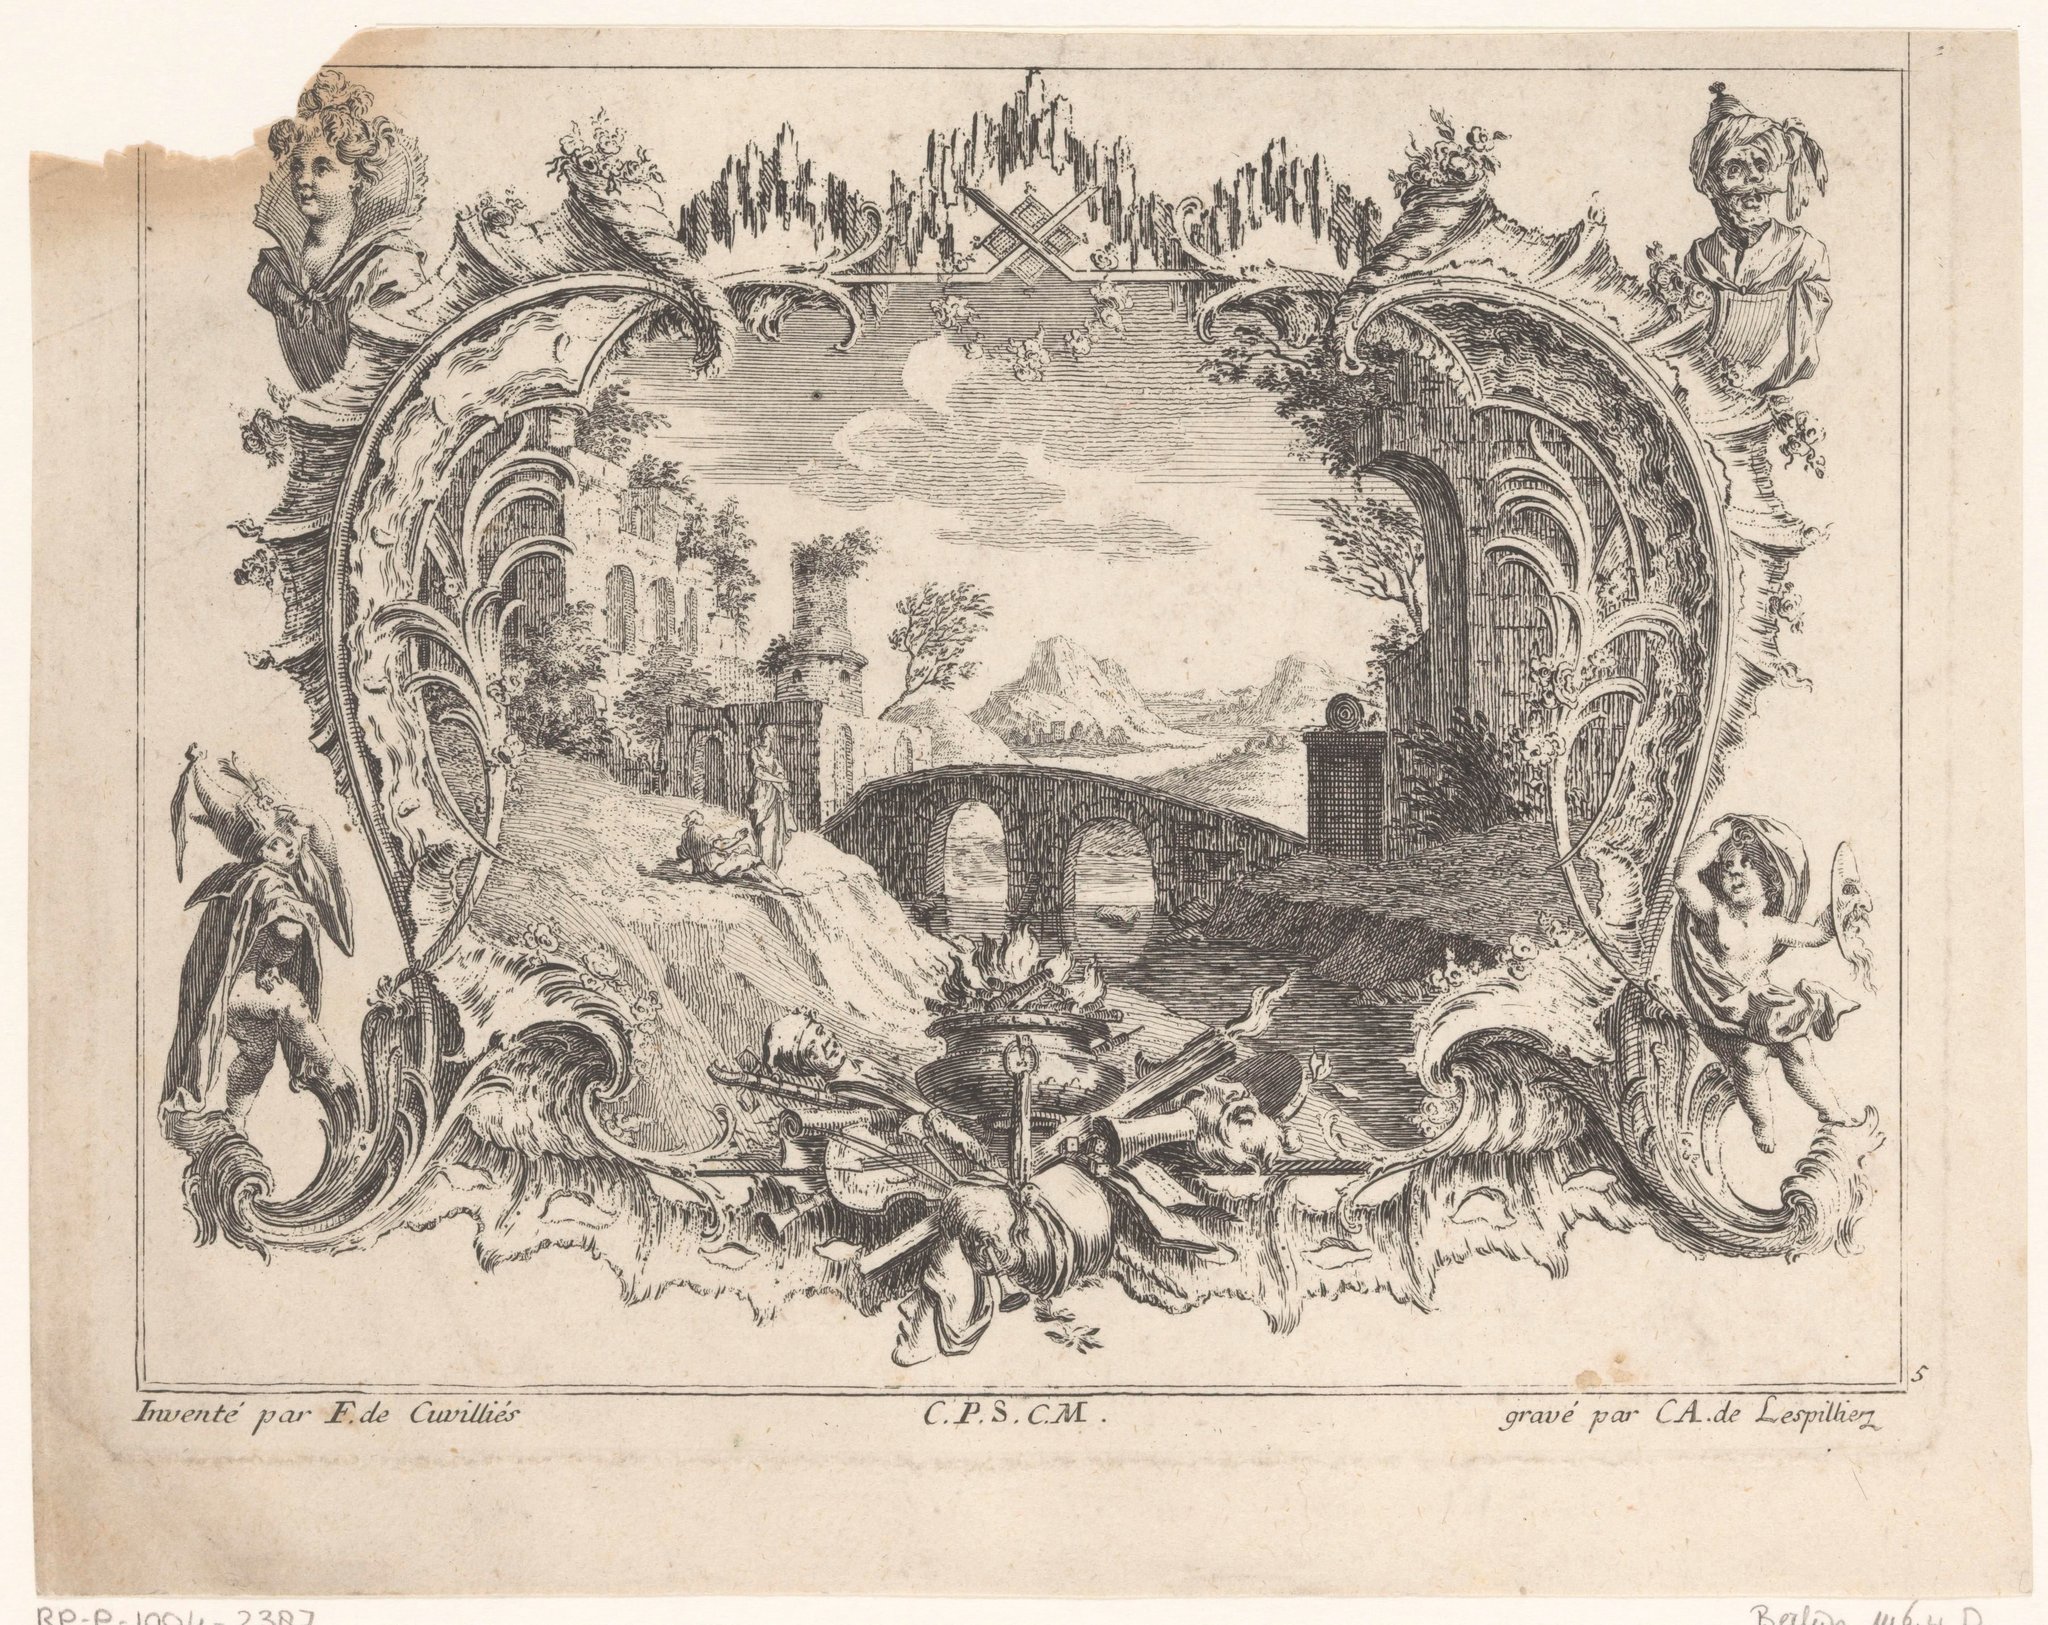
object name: print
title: Twee figuren op een oever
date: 1745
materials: paper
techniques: etching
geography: germany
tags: musical instruments; group of musical instruments, river, cupids: 'amores', 'amoretti', 'putti', landscape with bridge, viaduct or aqueduct (+ city(-scape) with figures, staffage)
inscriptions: collector's mark: Lugt 2228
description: Twee figuren bevinden zich op een oever van een rivier, achter hen een brug en ruïnes. Rondom de voorstelling een omlijsting met oosterse figuren, putti en muziekinstrumenten.